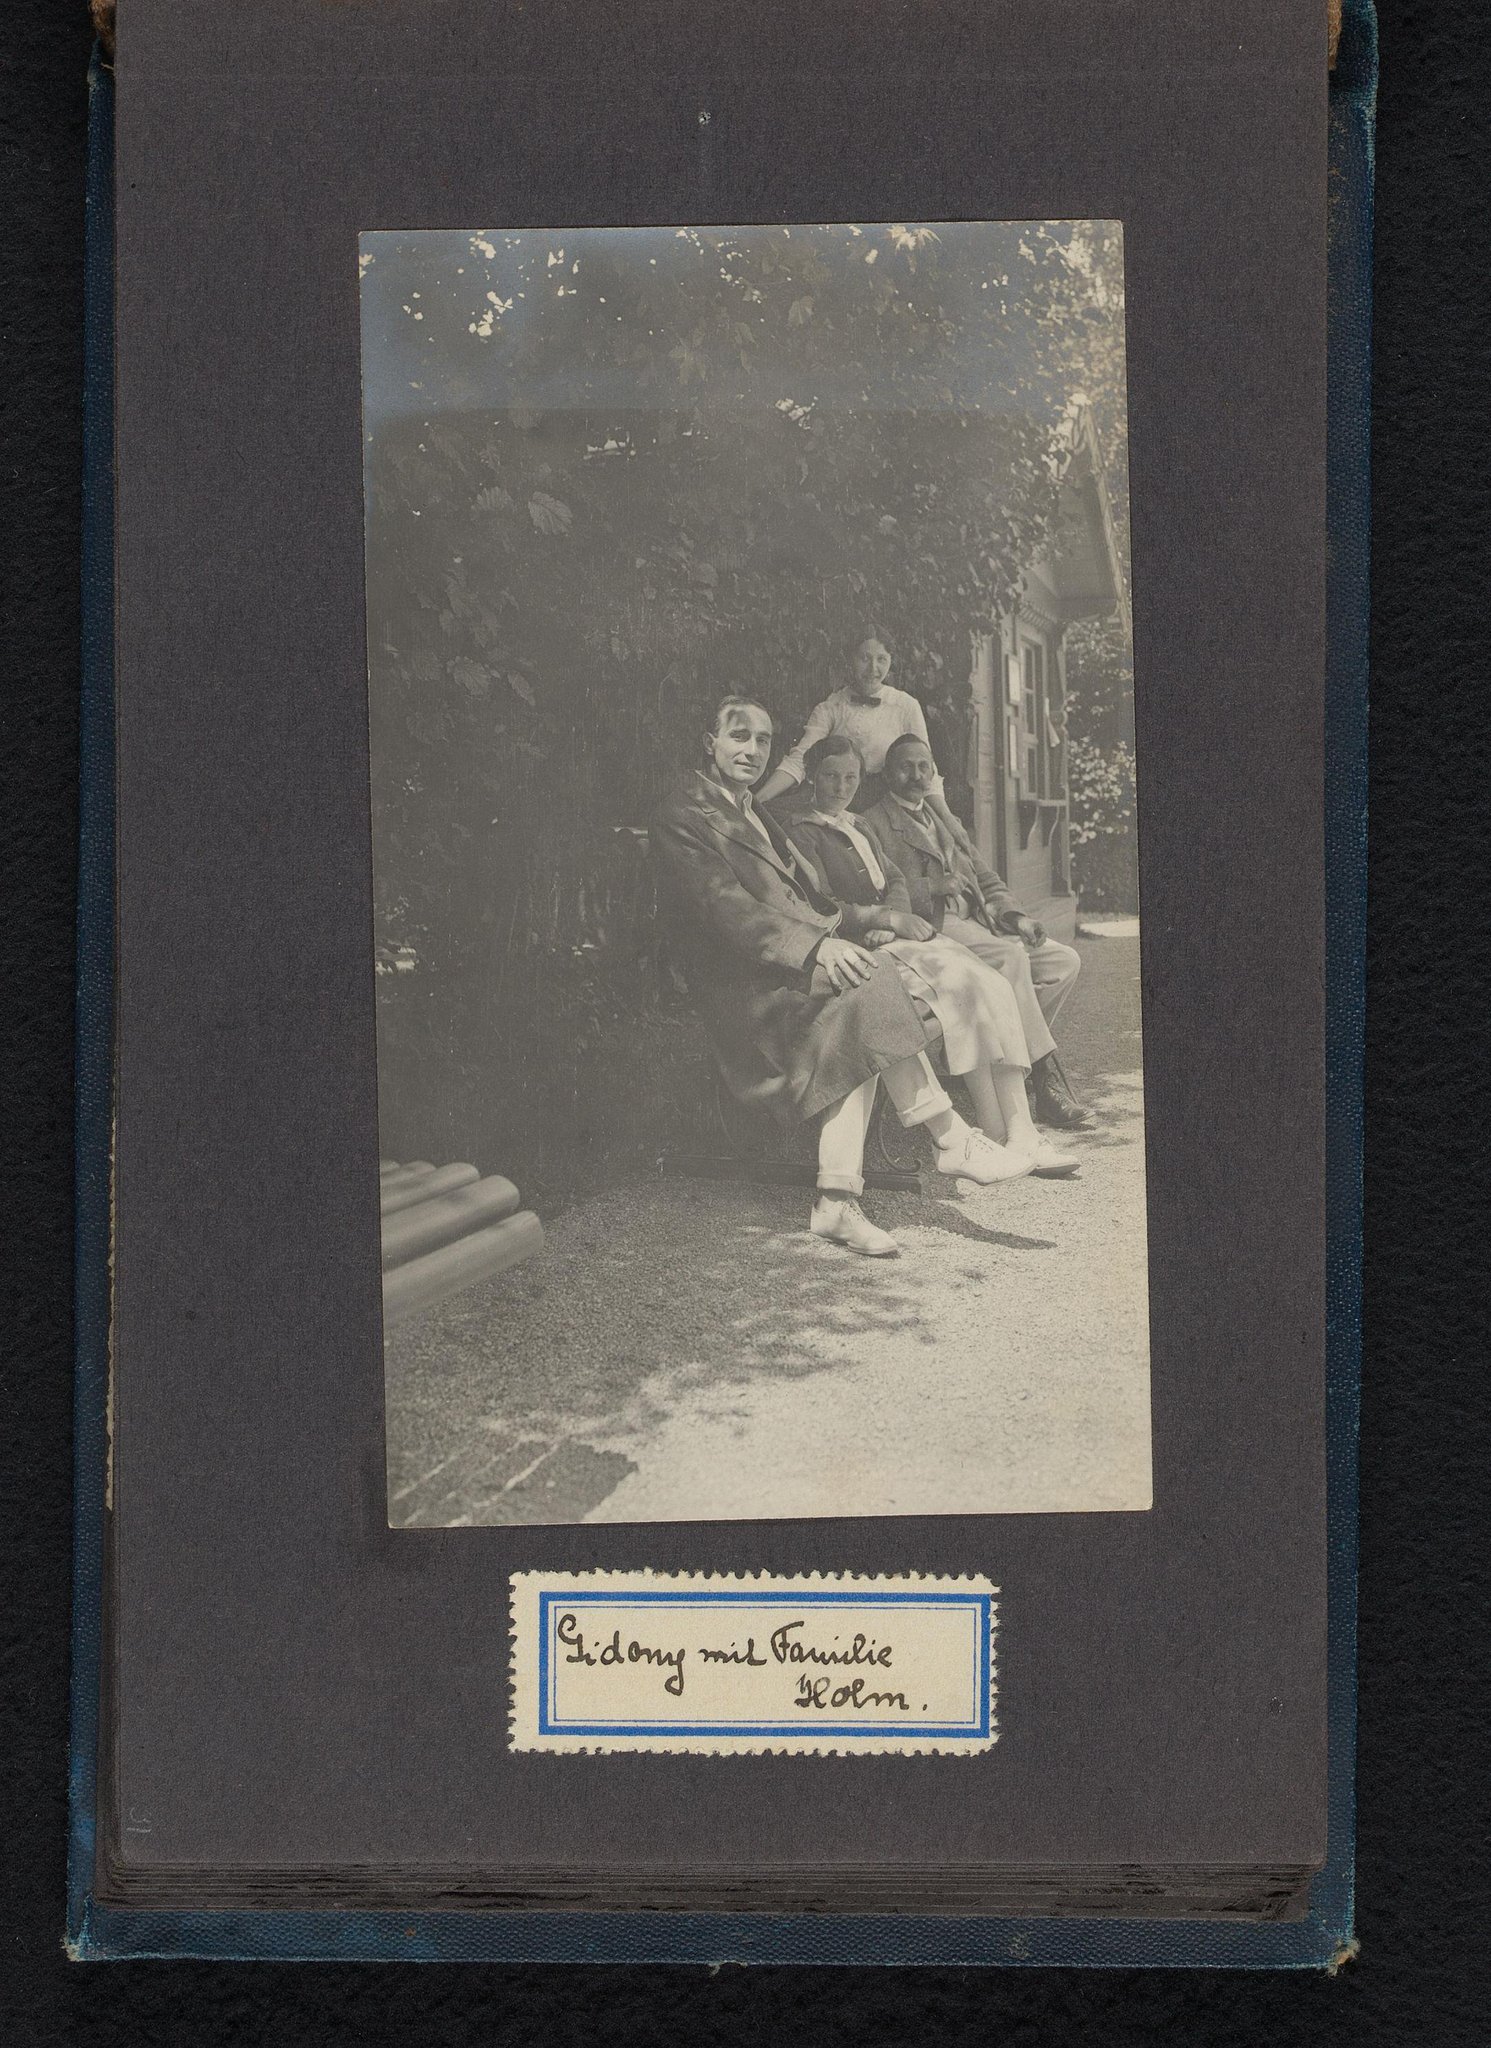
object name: photograph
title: Op de tennisbaan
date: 1913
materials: paper, photographic support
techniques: gelatin silver print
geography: switzerland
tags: else wachenheimer-moos, tennis, lawn-tennis, switzerland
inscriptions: inscription: ‘Gidony met Familie Holm.’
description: Albumblad met een foto van Gidony met de familie Holm, naast de tennisbaan, bij Hotel Waldhaus Vulpera, Zwitserland. Onderdeel van het fotoalbum van Else Wachenheimer-Moos en haar broers Arthur en Willy Moos en anderen in de periode 1913-1918.